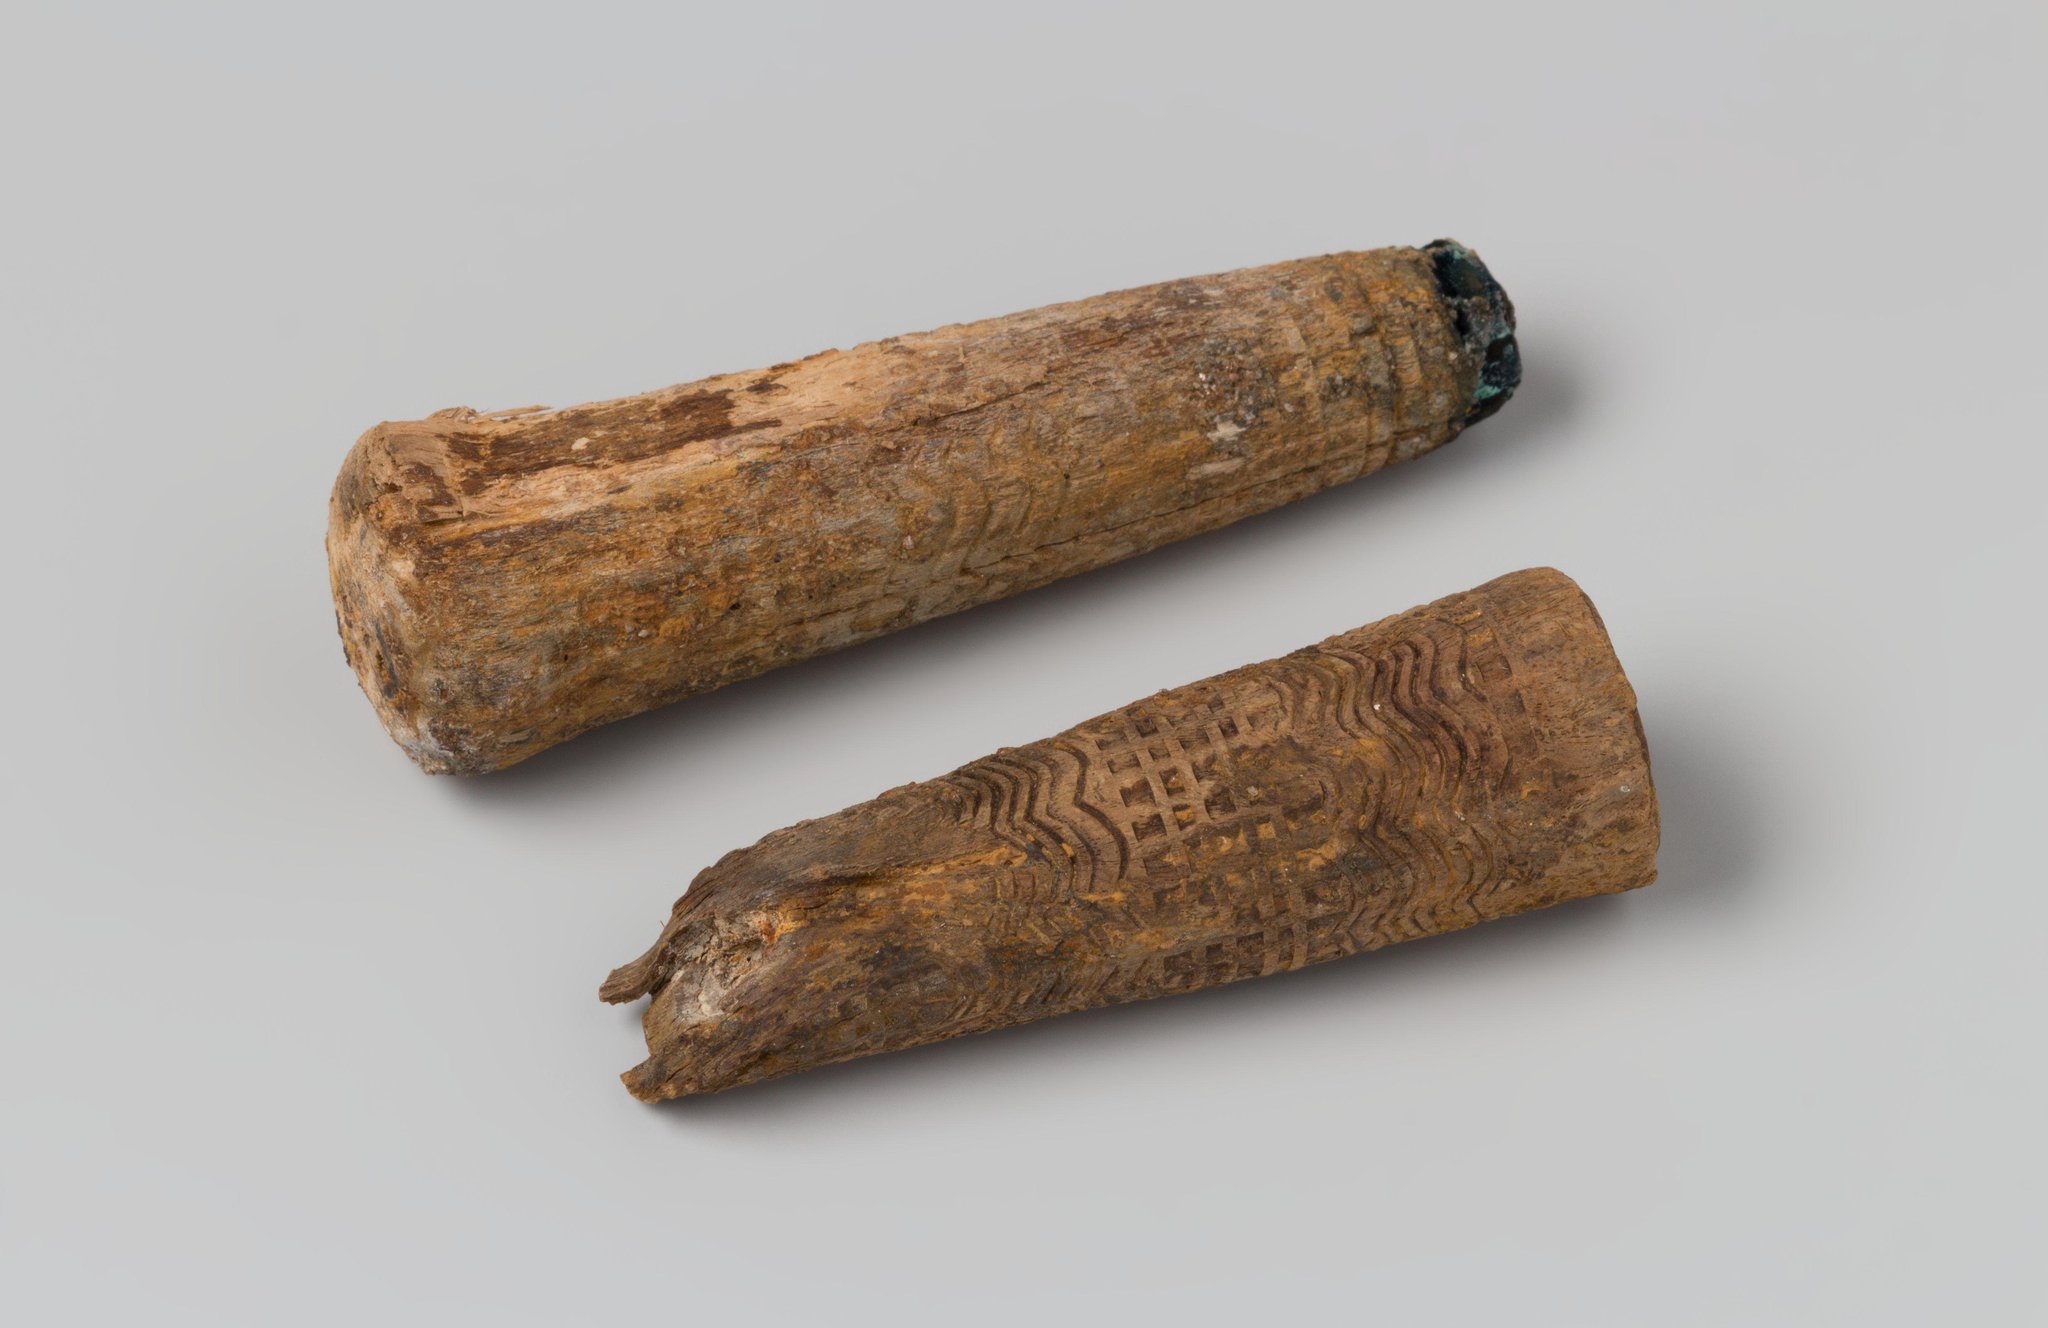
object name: knife handle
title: Messenheften uit het wrak van de Oost-Indiëvaarder Hollandia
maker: Anonymous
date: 1700-1743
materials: copper, wood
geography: netherlands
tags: verenigde oostindische compagnie, hollandia (schip), annet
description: Knife, handle, cylindrical: tapering; id. NG 1979-403H, ferrule, id. NG 1980-27H426.